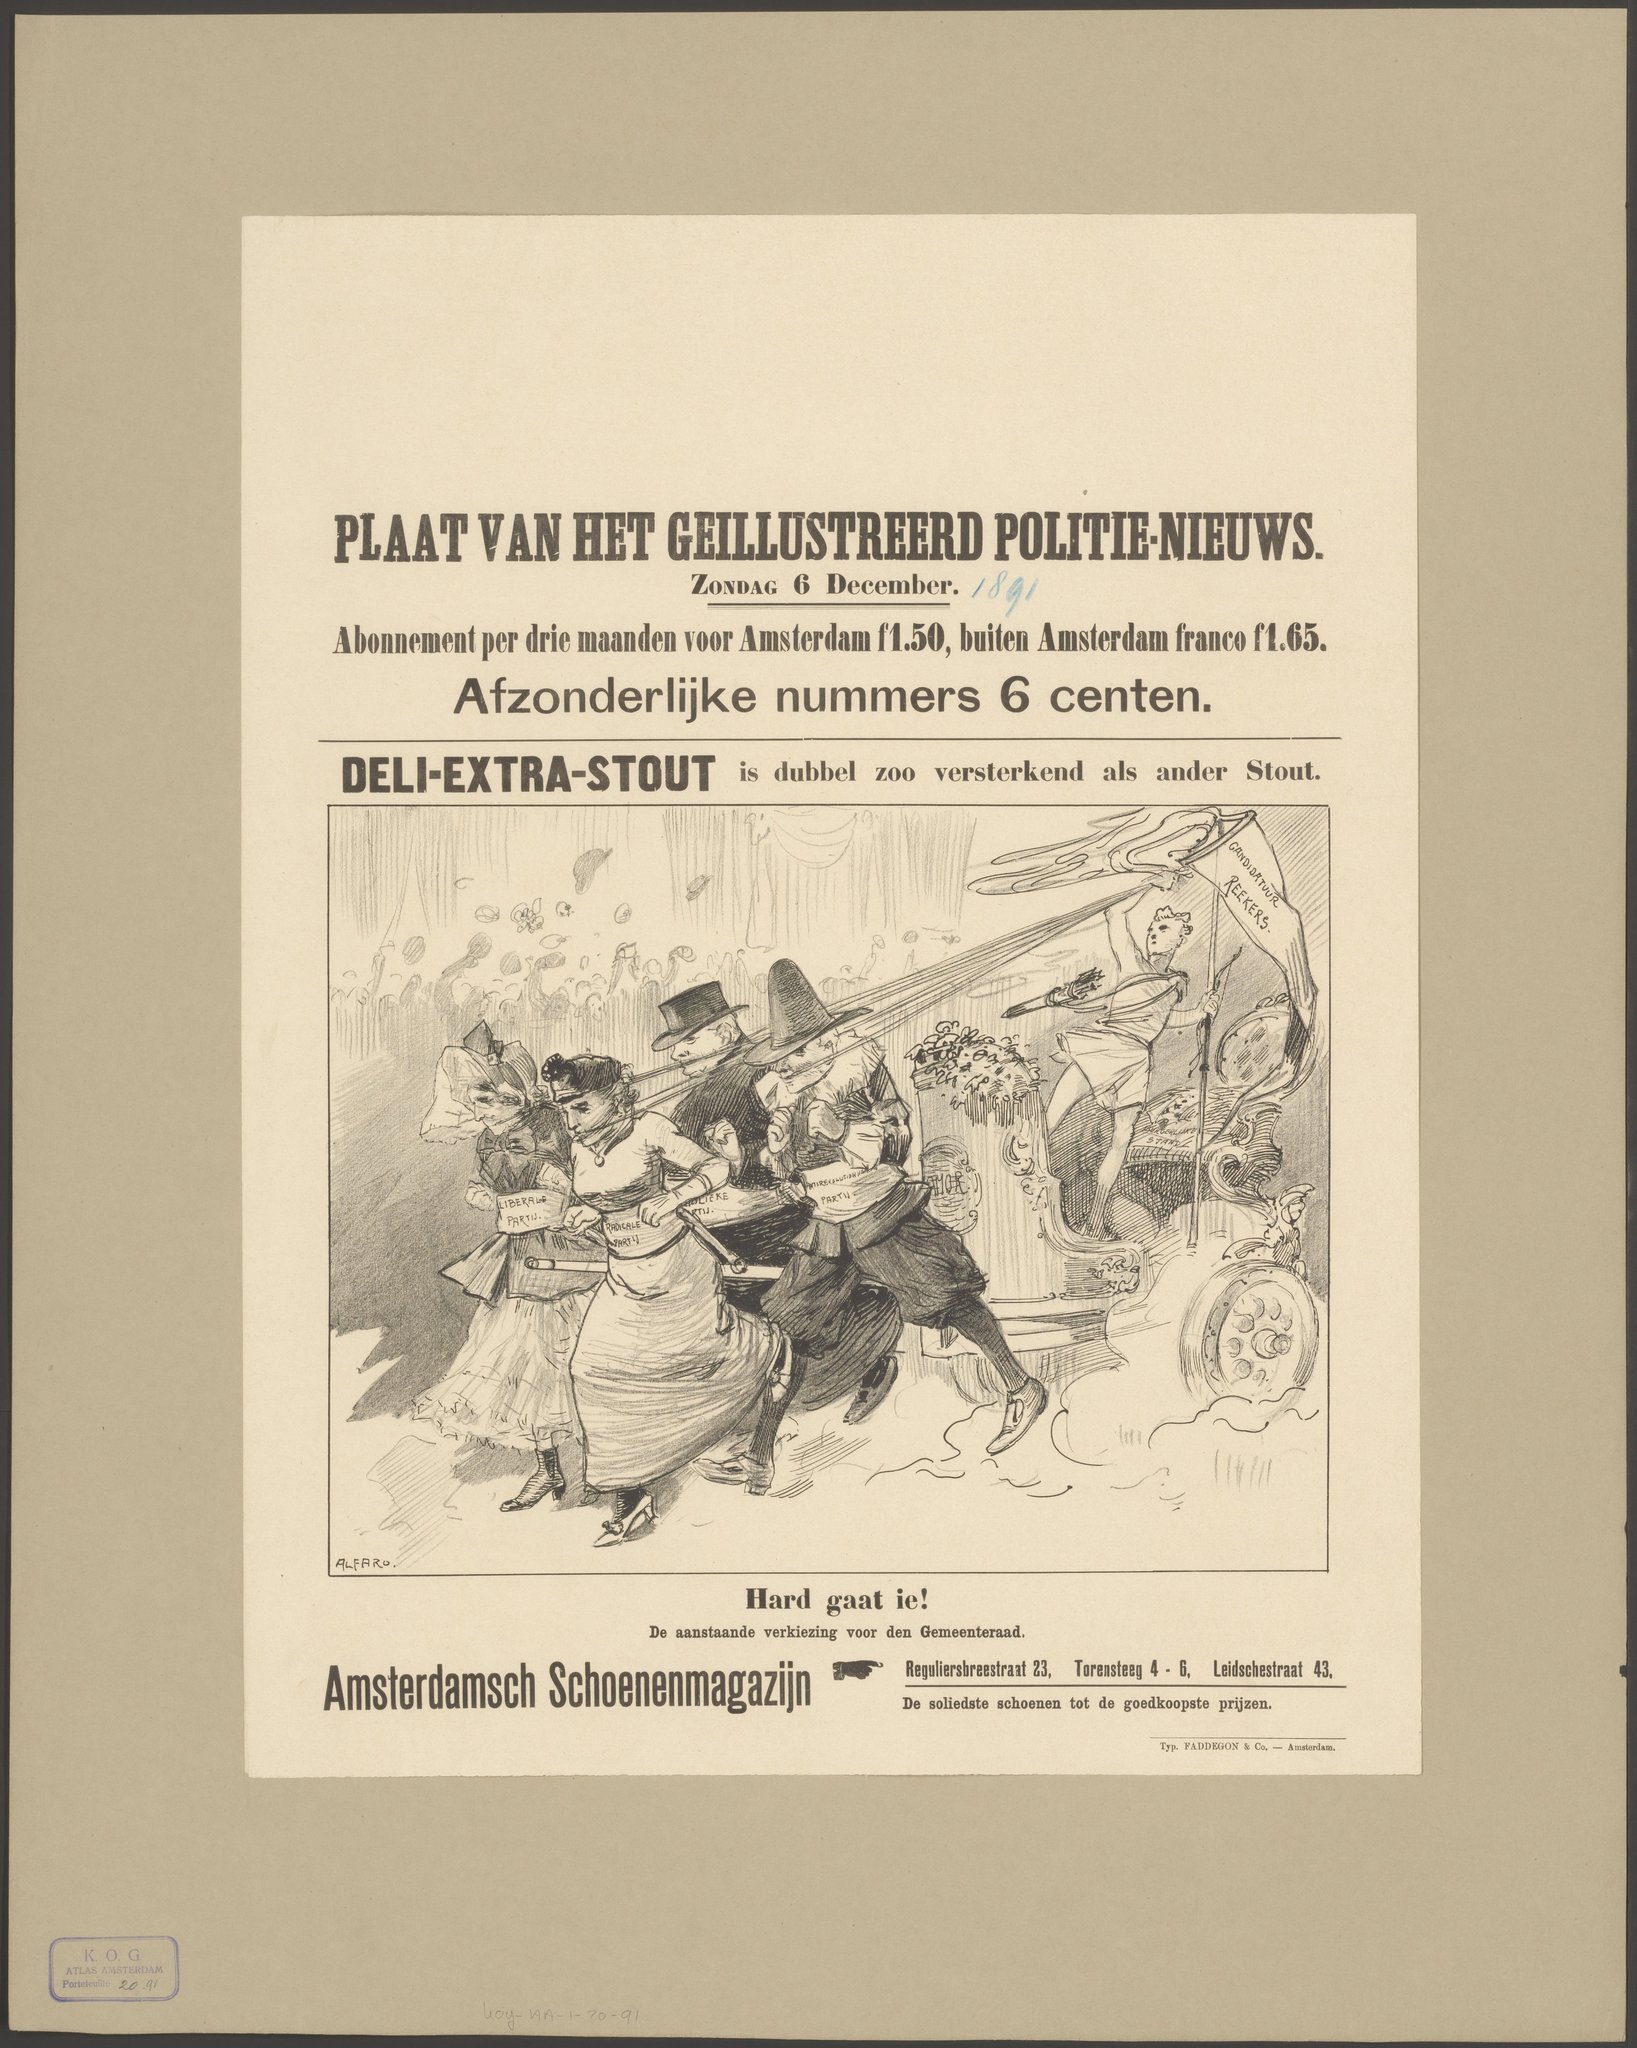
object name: cartoon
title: Hard gaat ie!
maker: alfaro reijding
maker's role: draughtsman, engineer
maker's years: 1863-1930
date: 1891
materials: paper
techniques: letterpress printing, lithograph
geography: amsterdam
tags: chariot, triumphal car, political caricatures and satires, amsterdam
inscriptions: collector's mark: Lugt 1641b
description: Gepubliceerd als bijvoegsel van 'Geïllustreerd Politie-Nieuws', 6 december 1891.